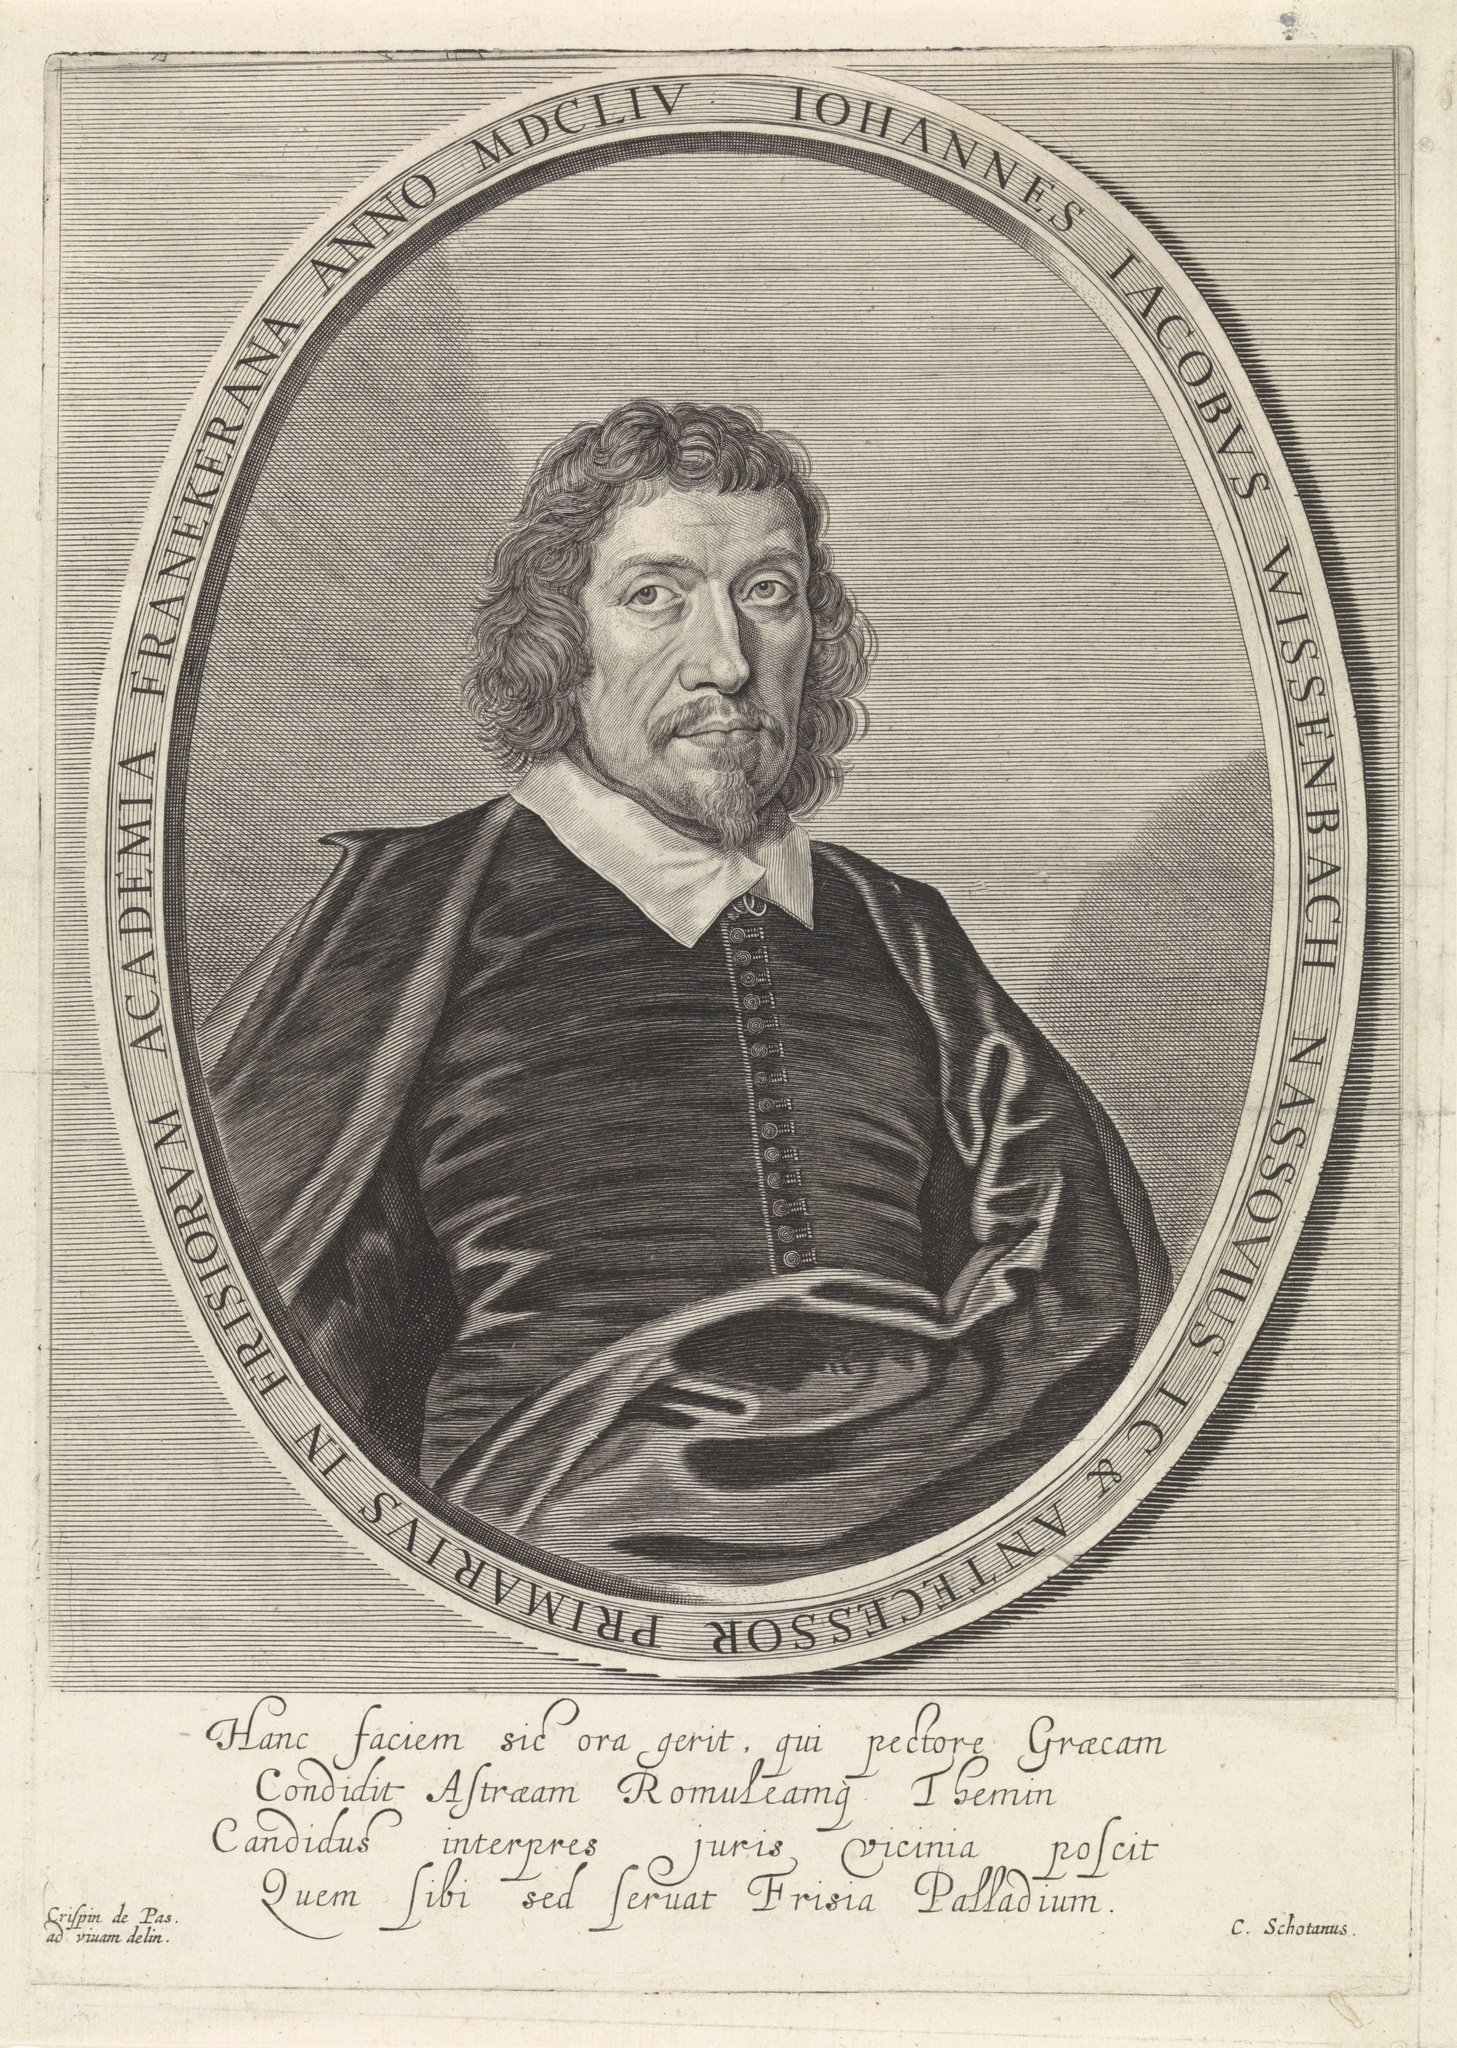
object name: print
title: Portret van Johannes Jacobus Wissenbach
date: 1654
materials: paper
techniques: engraving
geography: amsterdam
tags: professor, johannes jacobus wissenbach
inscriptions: collector's mark: Lugt 2228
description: Portret van Johannes Jacobus Wissenbach, professor te Franeker. In de marge een vierregelig lofdicht in het Latijn.